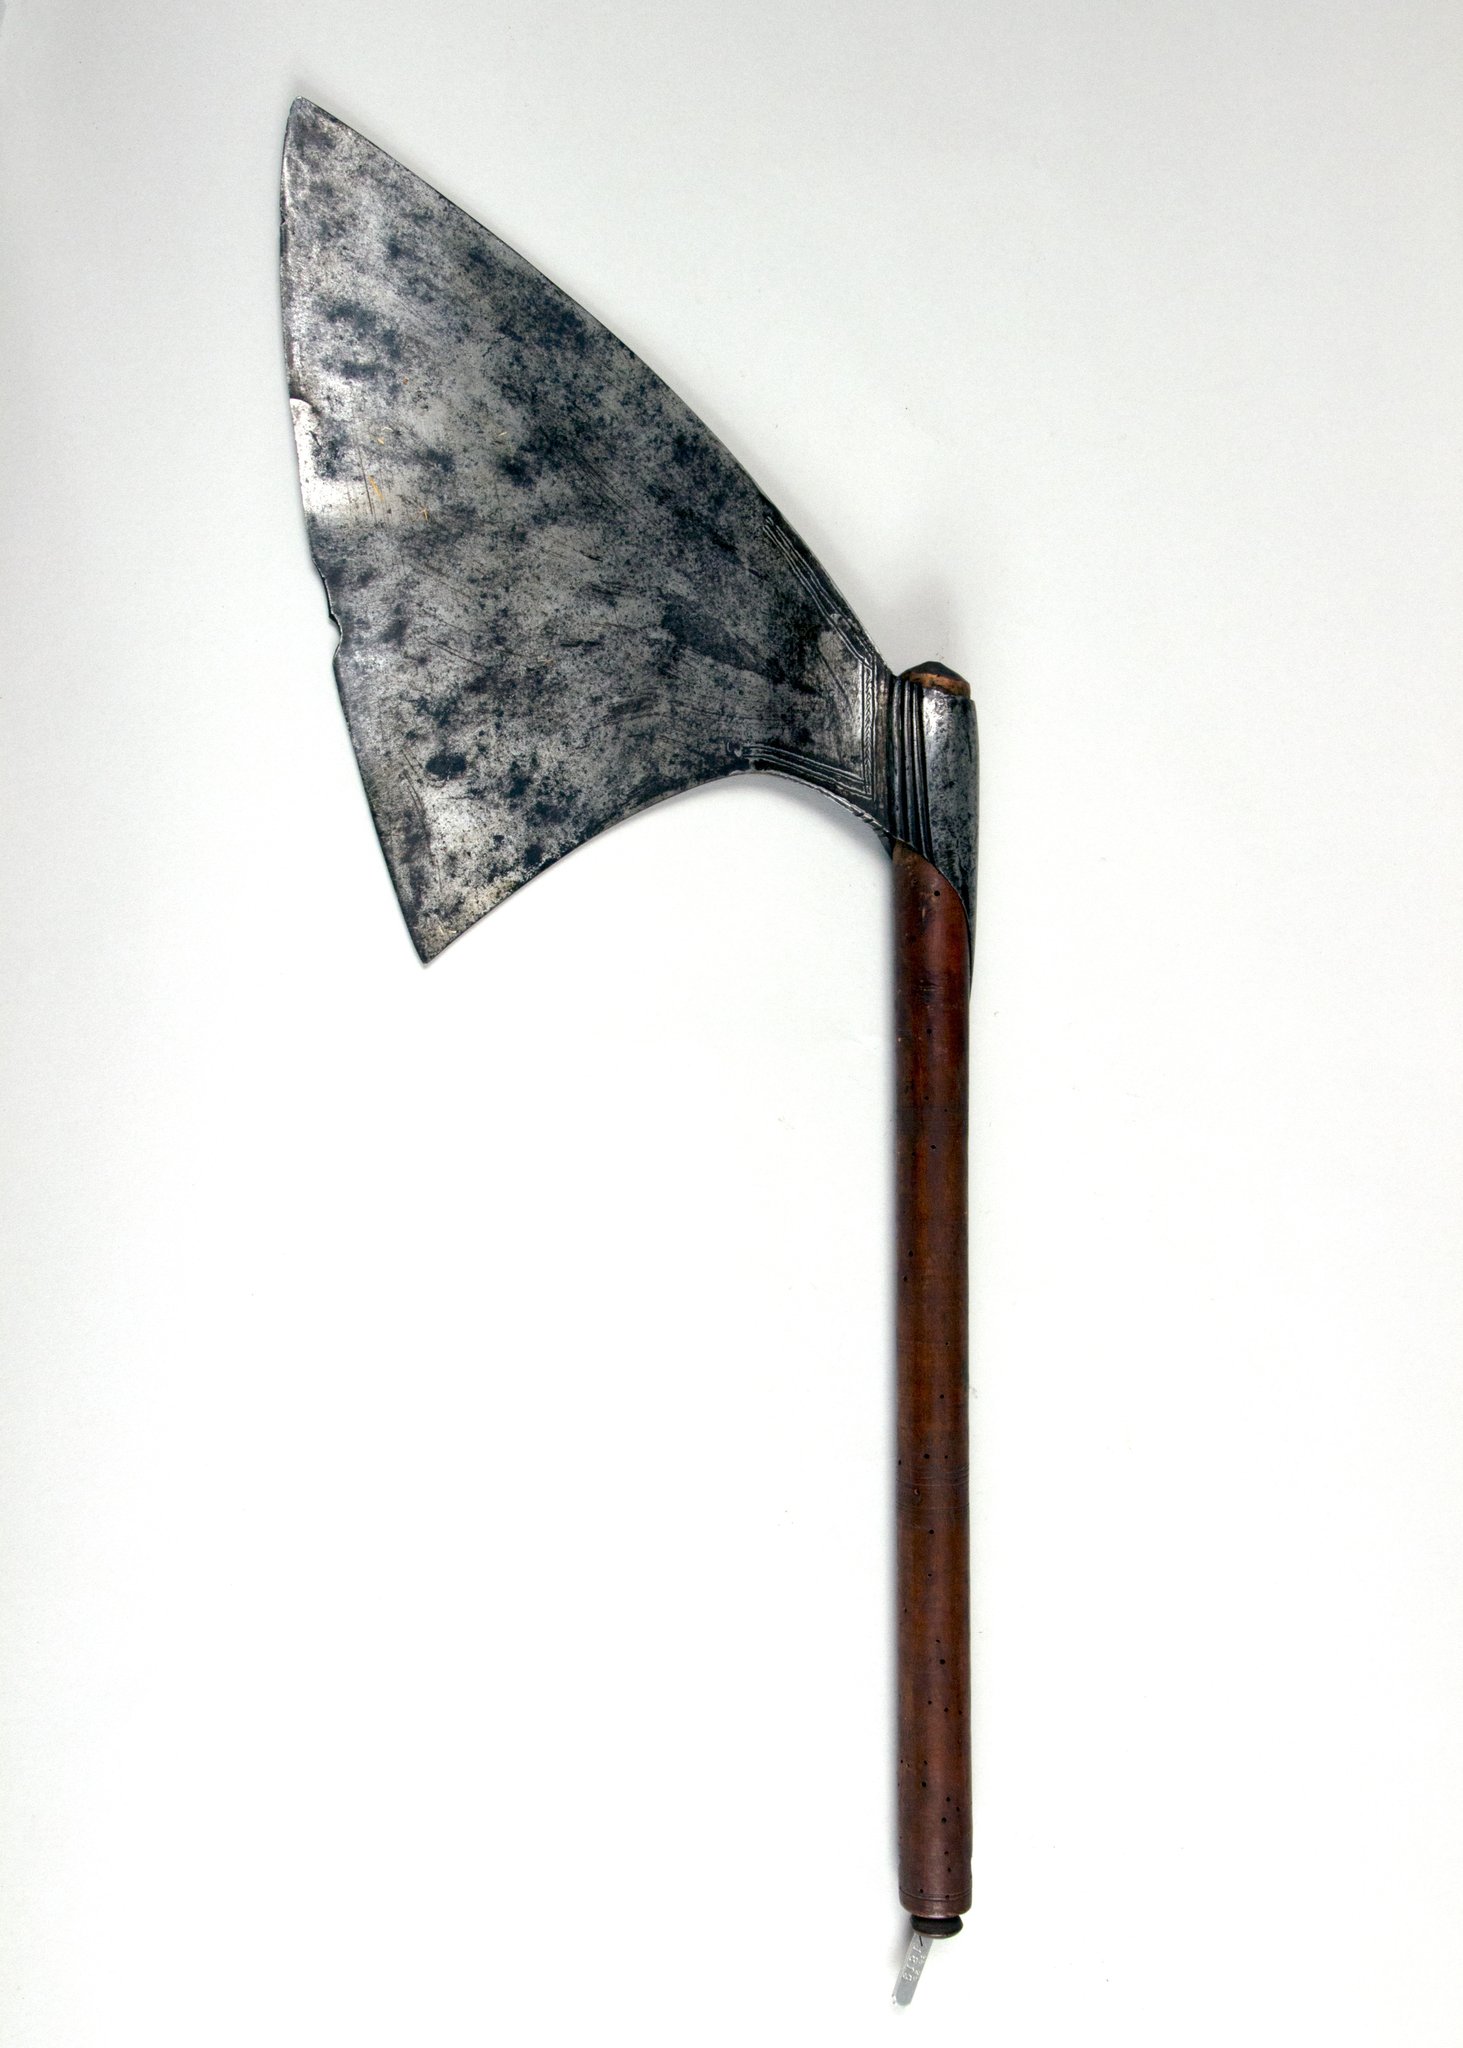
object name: axe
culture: indian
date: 1701-1900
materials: iron, wood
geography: india